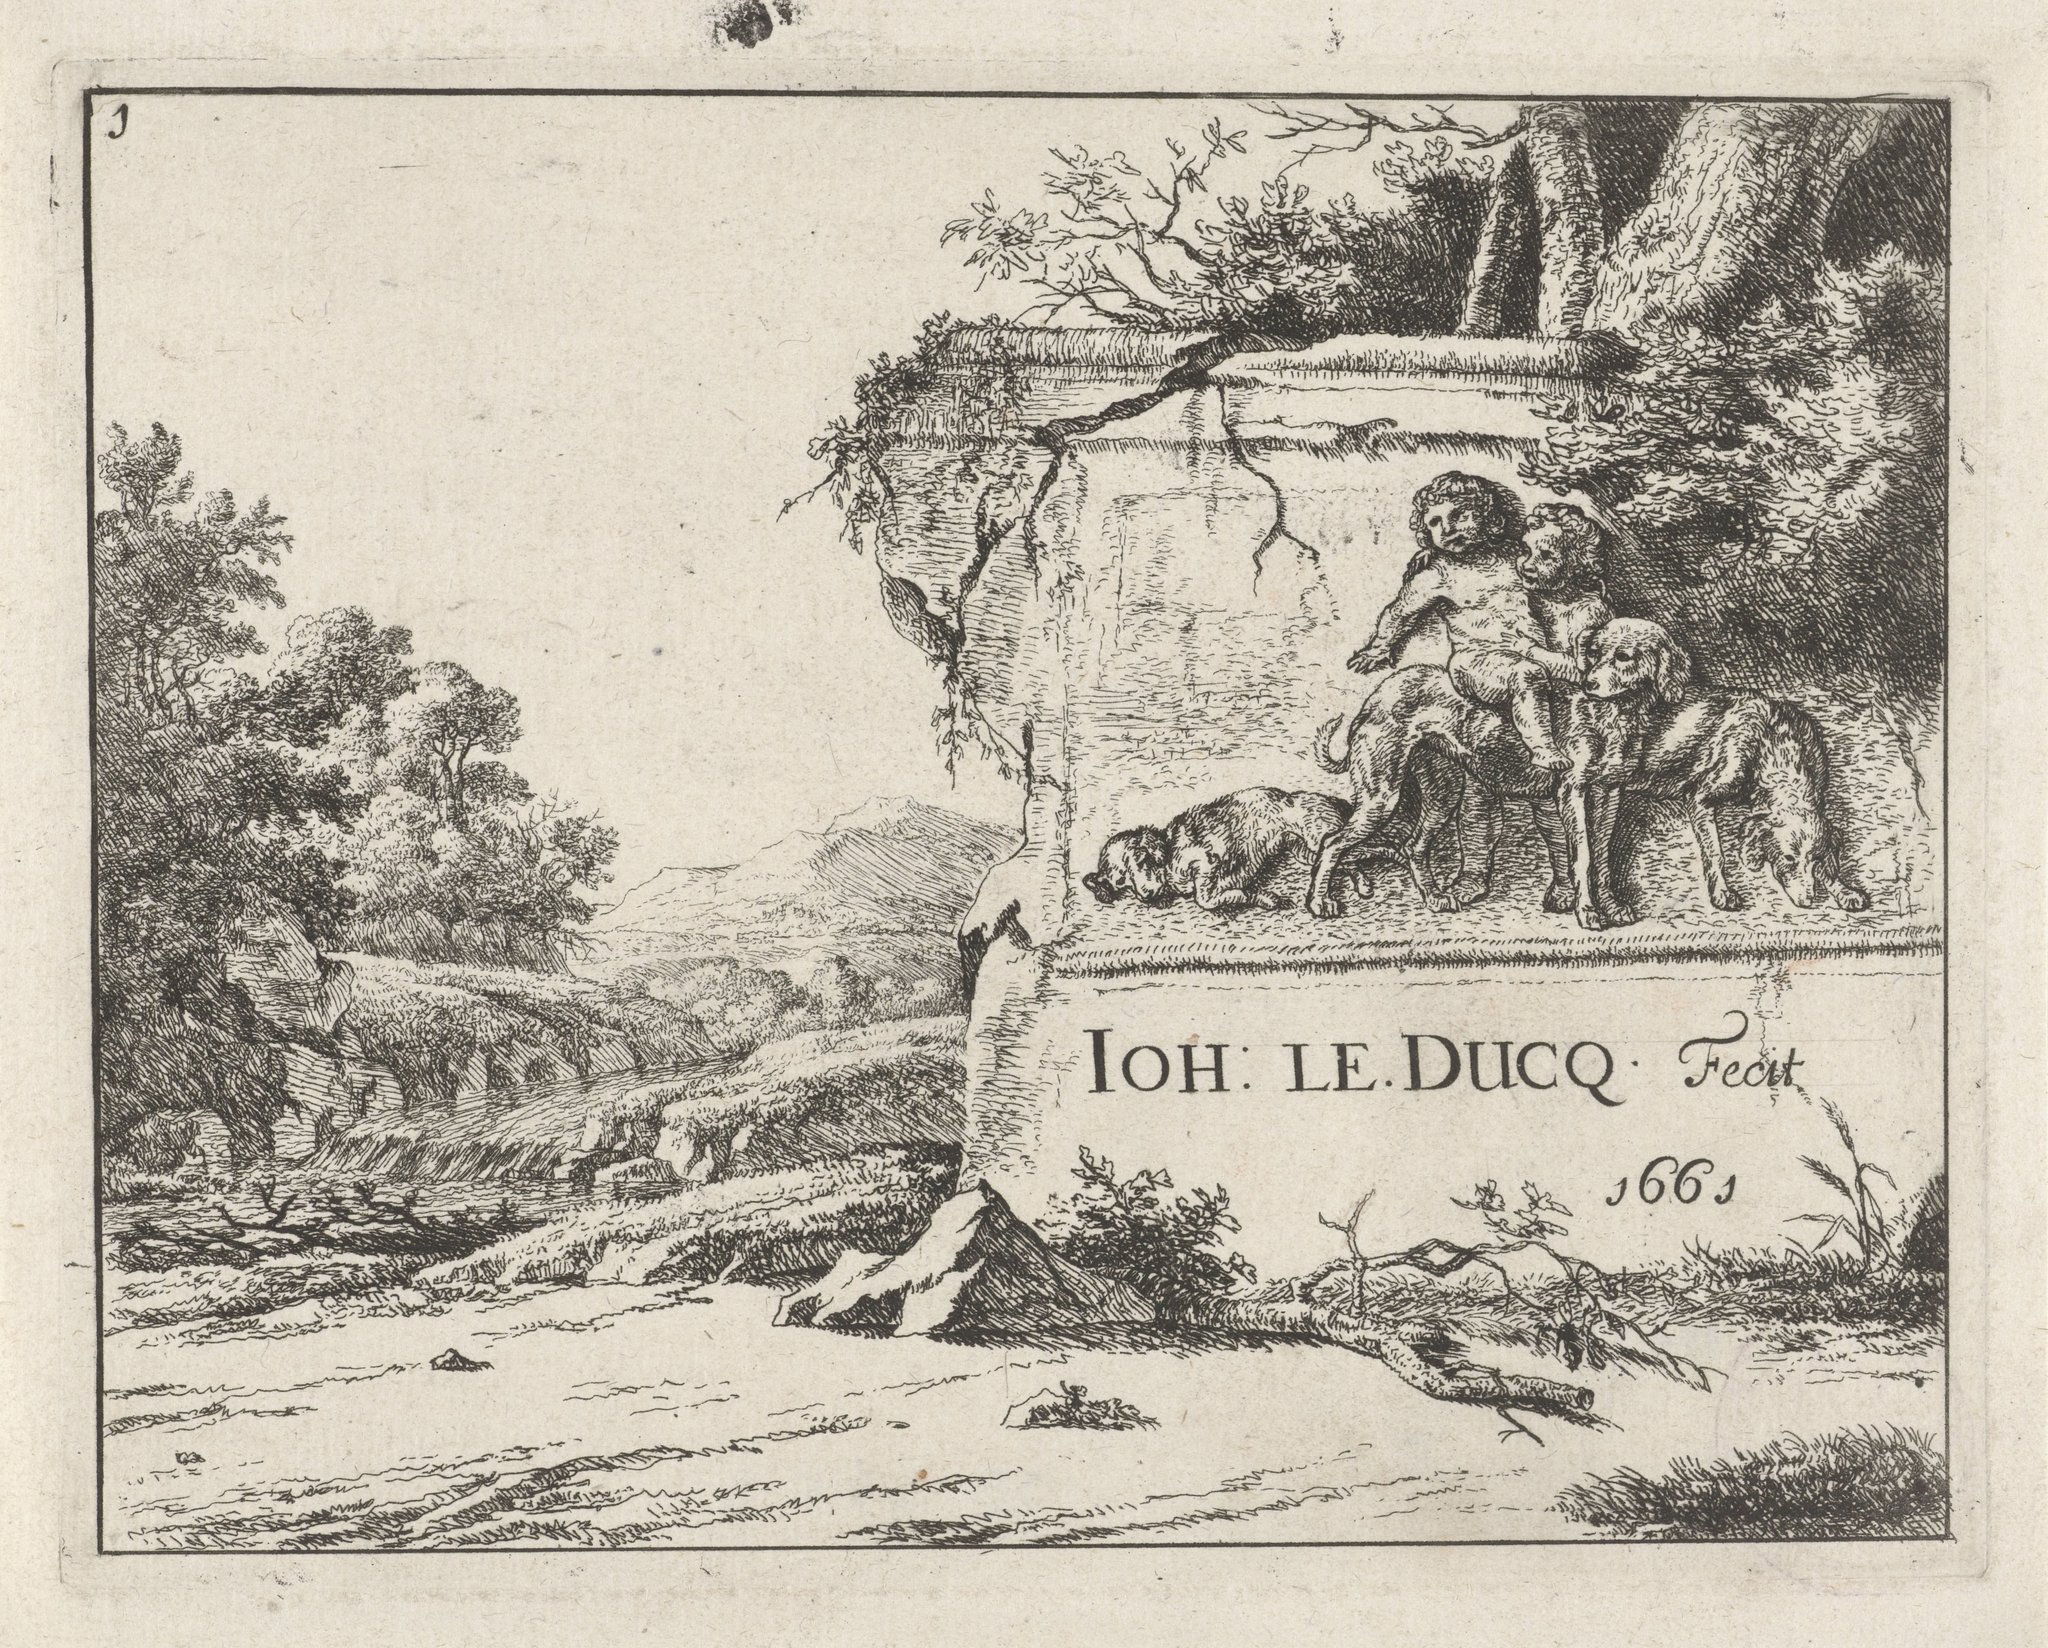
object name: print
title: Honden in een landschap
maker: johan le ducq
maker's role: draughtsman, print maker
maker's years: 1629-1677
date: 1661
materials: paper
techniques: etching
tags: landscapes - hh - ideal landscapes, dog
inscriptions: collector's mark: Lugt 240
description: Gezicht op een ruïne, gelegen in een landschap met rivier. De ruïne is versierd met een reliëf van twee naakte kinderen die met honden spelen. De prent maakt deel uit van een achtdelige serie prenten met voorstellingen van honden in een landschap.